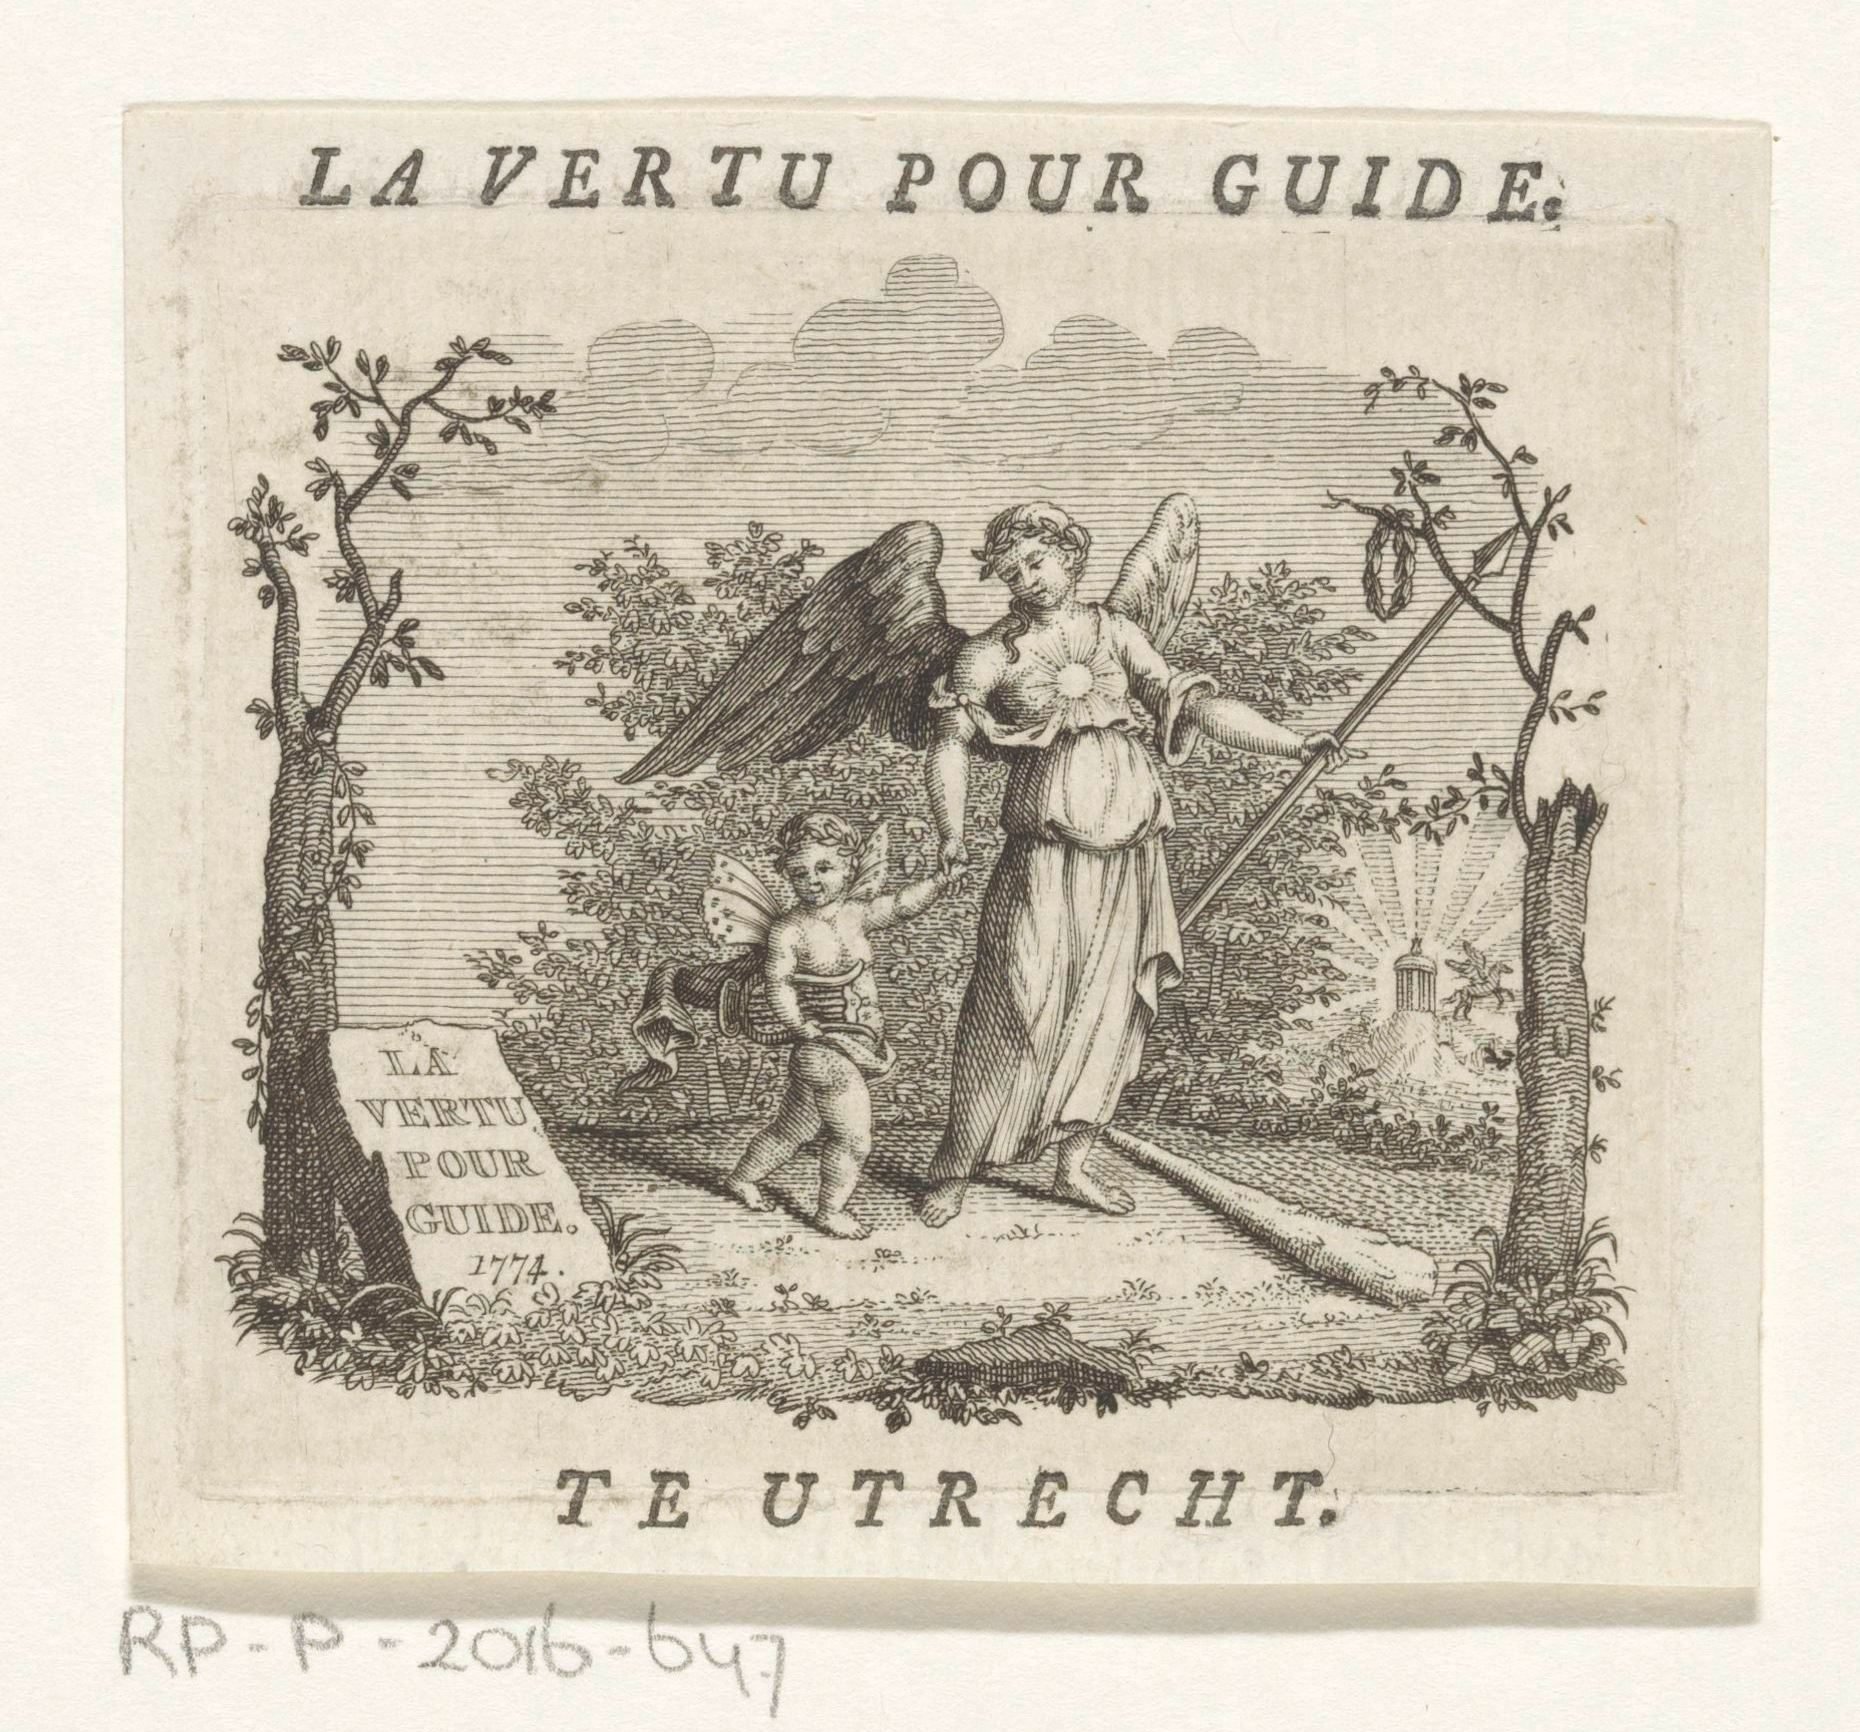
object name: print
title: La vertu pour guide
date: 1774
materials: paper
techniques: engraving, etching, letterpress printing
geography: utrecht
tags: the seven virtues (symbolized), virtuousness; 'amor di virtù', 'attione virtuosa', 'guida sicura de' veri honori', 'virtù', 'virtù insuperabile' (ripa)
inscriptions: collector's mark: Lugt 2228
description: Titelpagina voor: Merken, Lucretia Wilhelmina van. Artemines, Treurspel. Utrecht: S.n., 1774. Prent afkomstig uit een plakalbum met titelprenten, ornamenten etc. op blauw papier in 1983 uit elkaar gehaald.